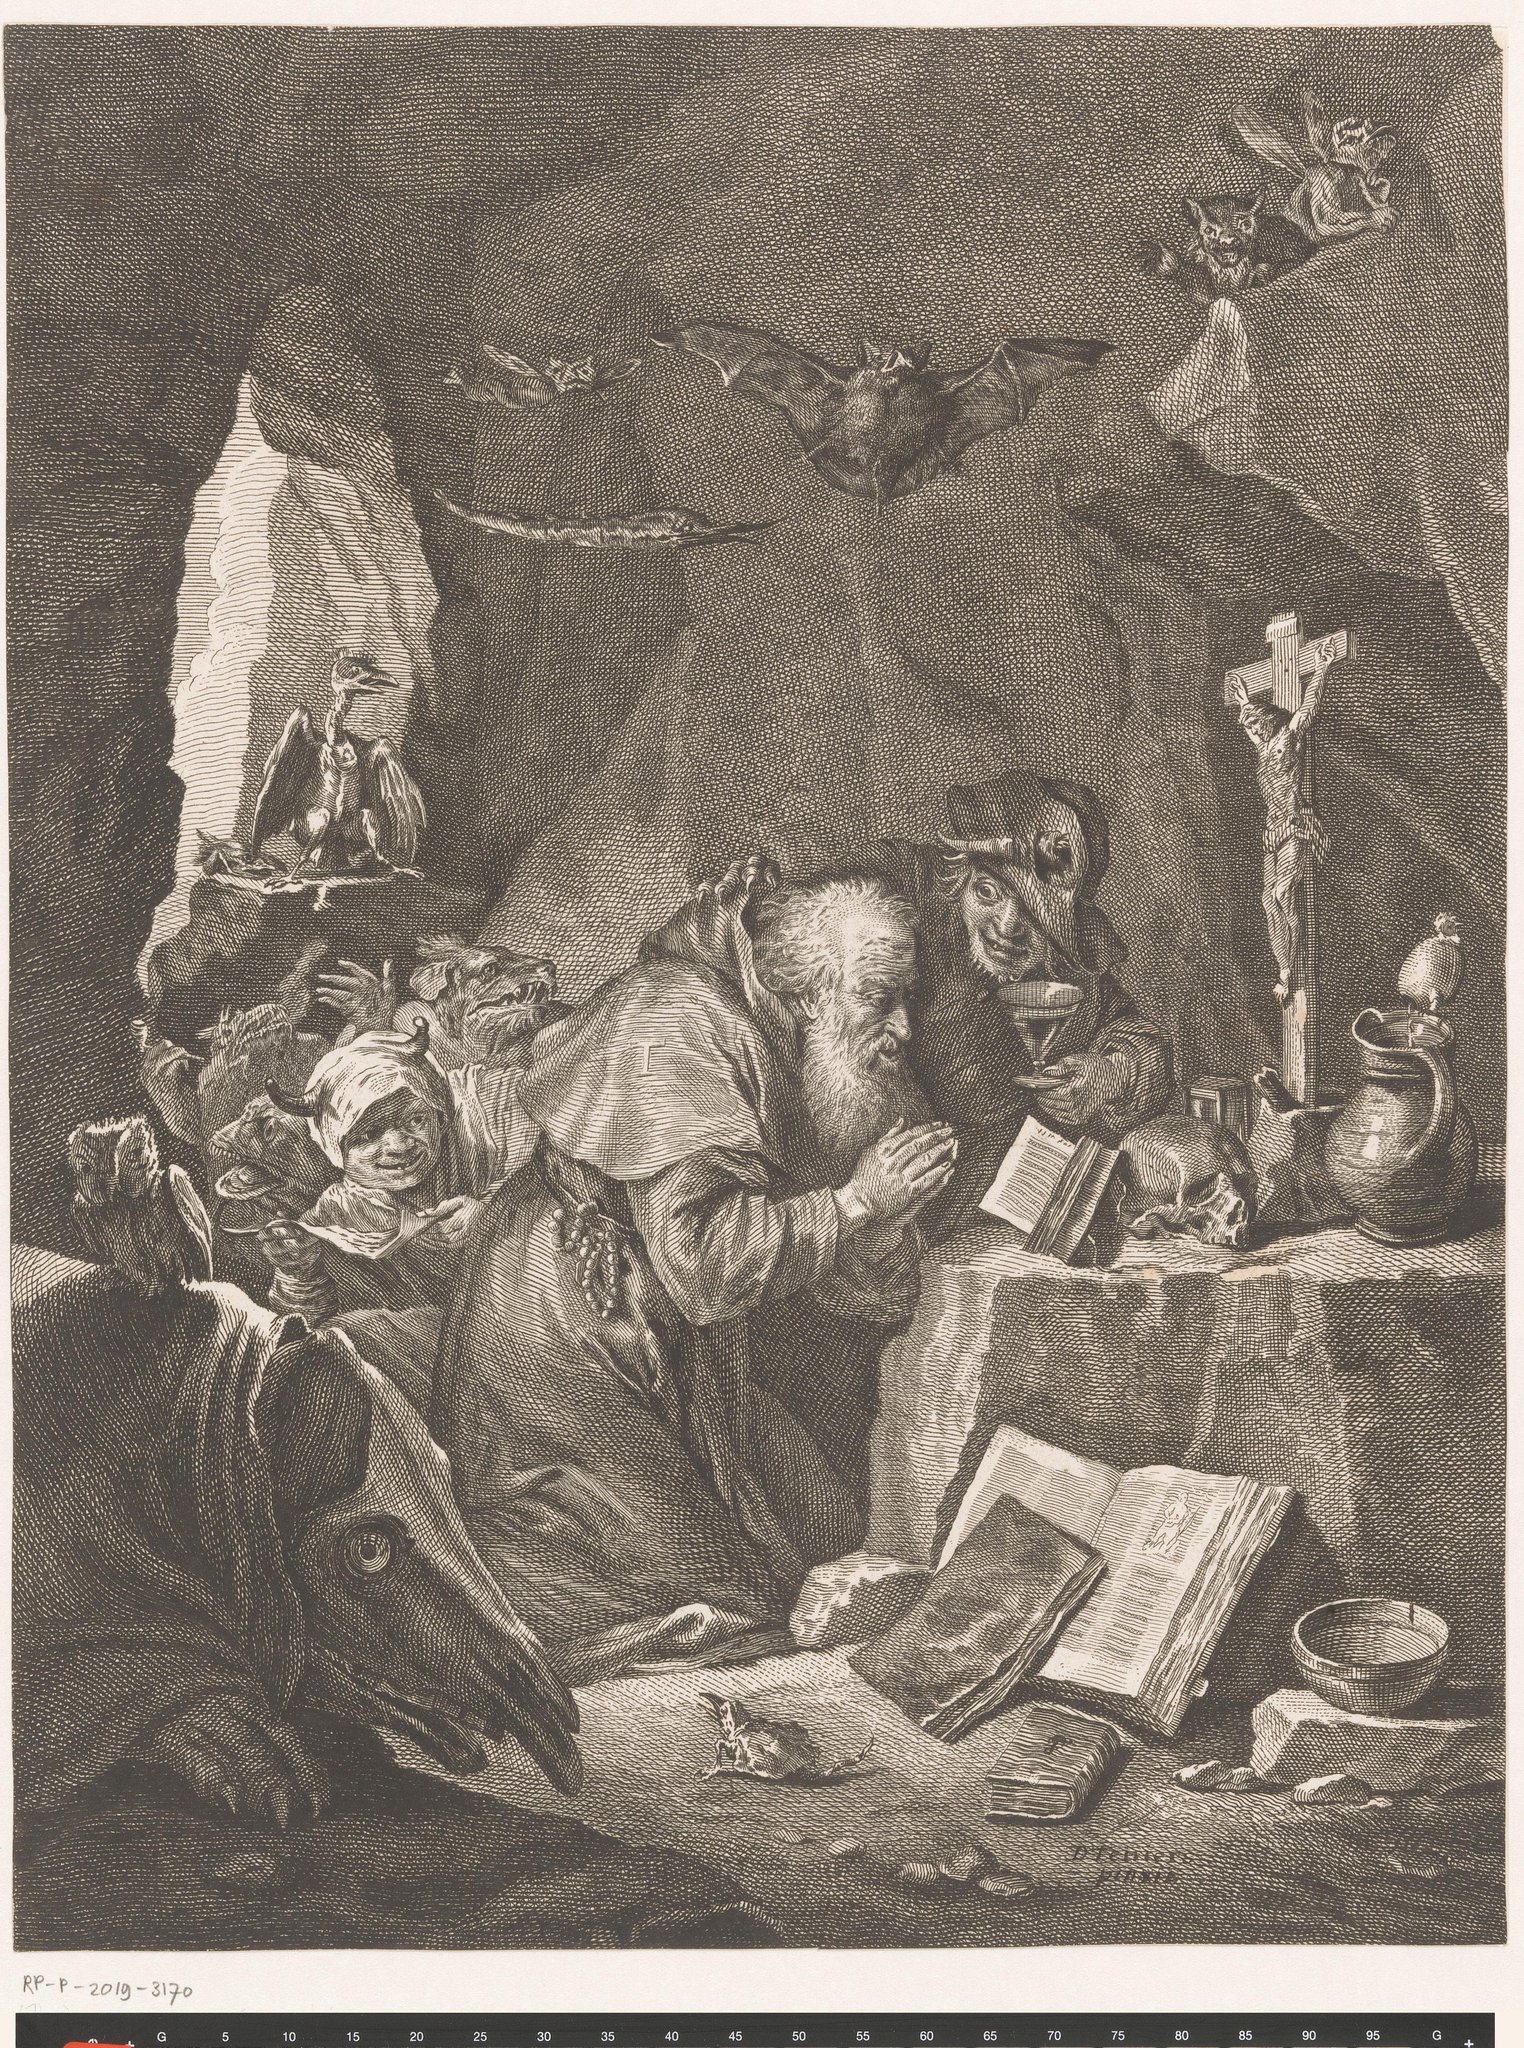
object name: print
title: Verzoeking van de heilige Antonius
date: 1700-1799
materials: paper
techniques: engraving, etching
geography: netherlands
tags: flying mammals: bat, devils in the form of (fabulous) animals, temptations of st. antony abbot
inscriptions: collector's mark: Lugt 2028, number: ‘N. 215’, collector's mark: Lugt 2228